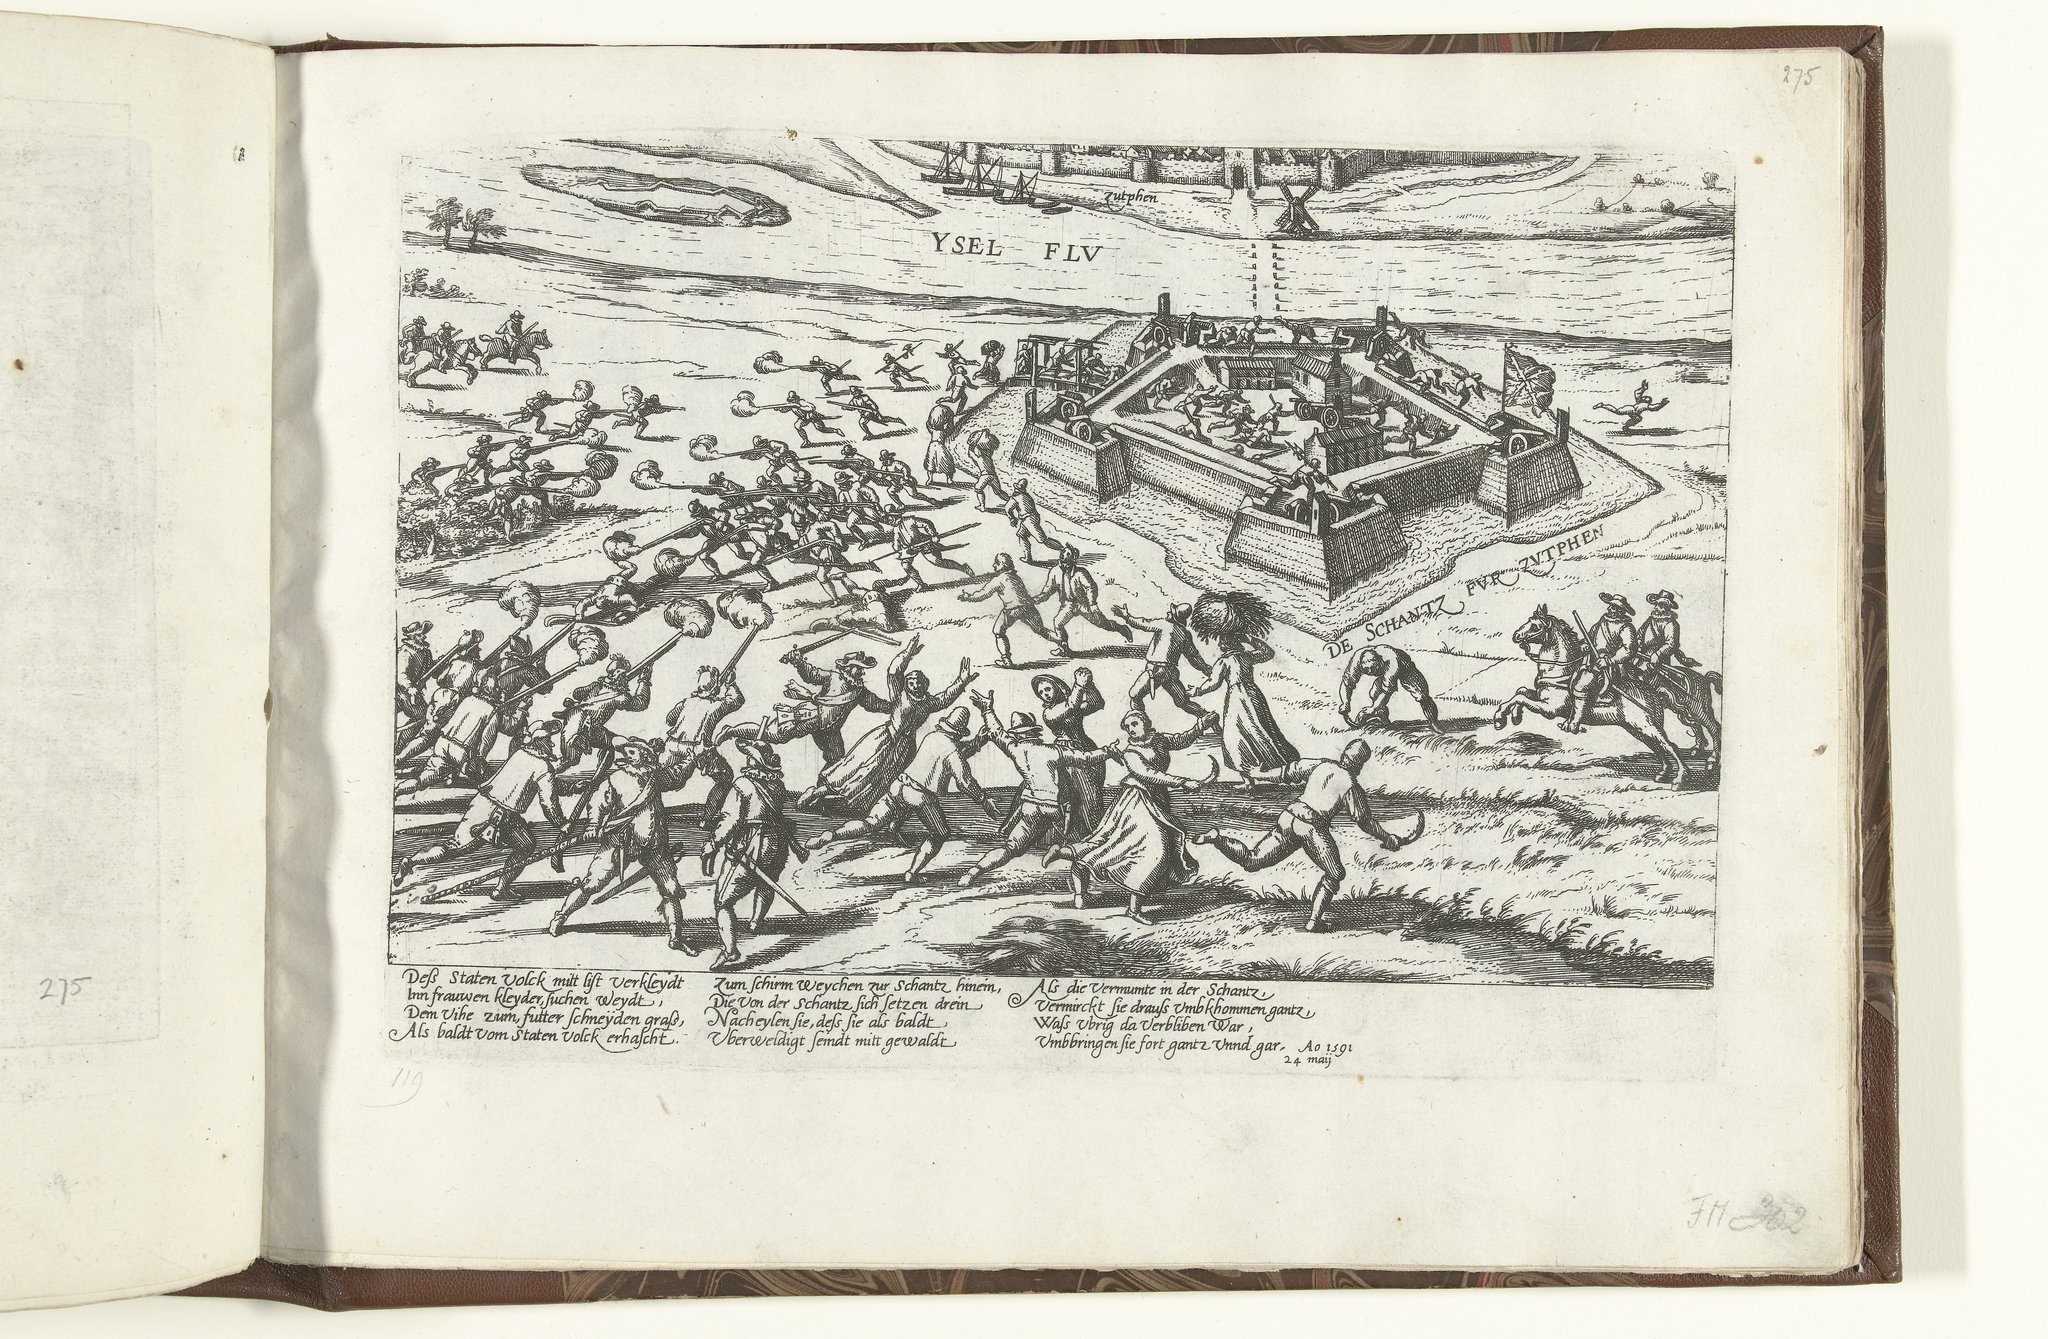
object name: album leaf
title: Serie 10: Nederlandse en Buitenlandse Gebeurtenissen, 1587-1612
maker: frans hogenberg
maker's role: print maker, publisher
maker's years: 1538-1590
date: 1591-1593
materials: paper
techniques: etching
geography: cologne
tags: capture of city (after the siege)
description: Inname van de schans bij Zutphen, 24 mei 1591. Verovering van de schans door middel van een list waarbij Staatse soldaten verkleed waren als boerinnen. Met onderschrift van 12 regels in het Duits. Ongenummerd.